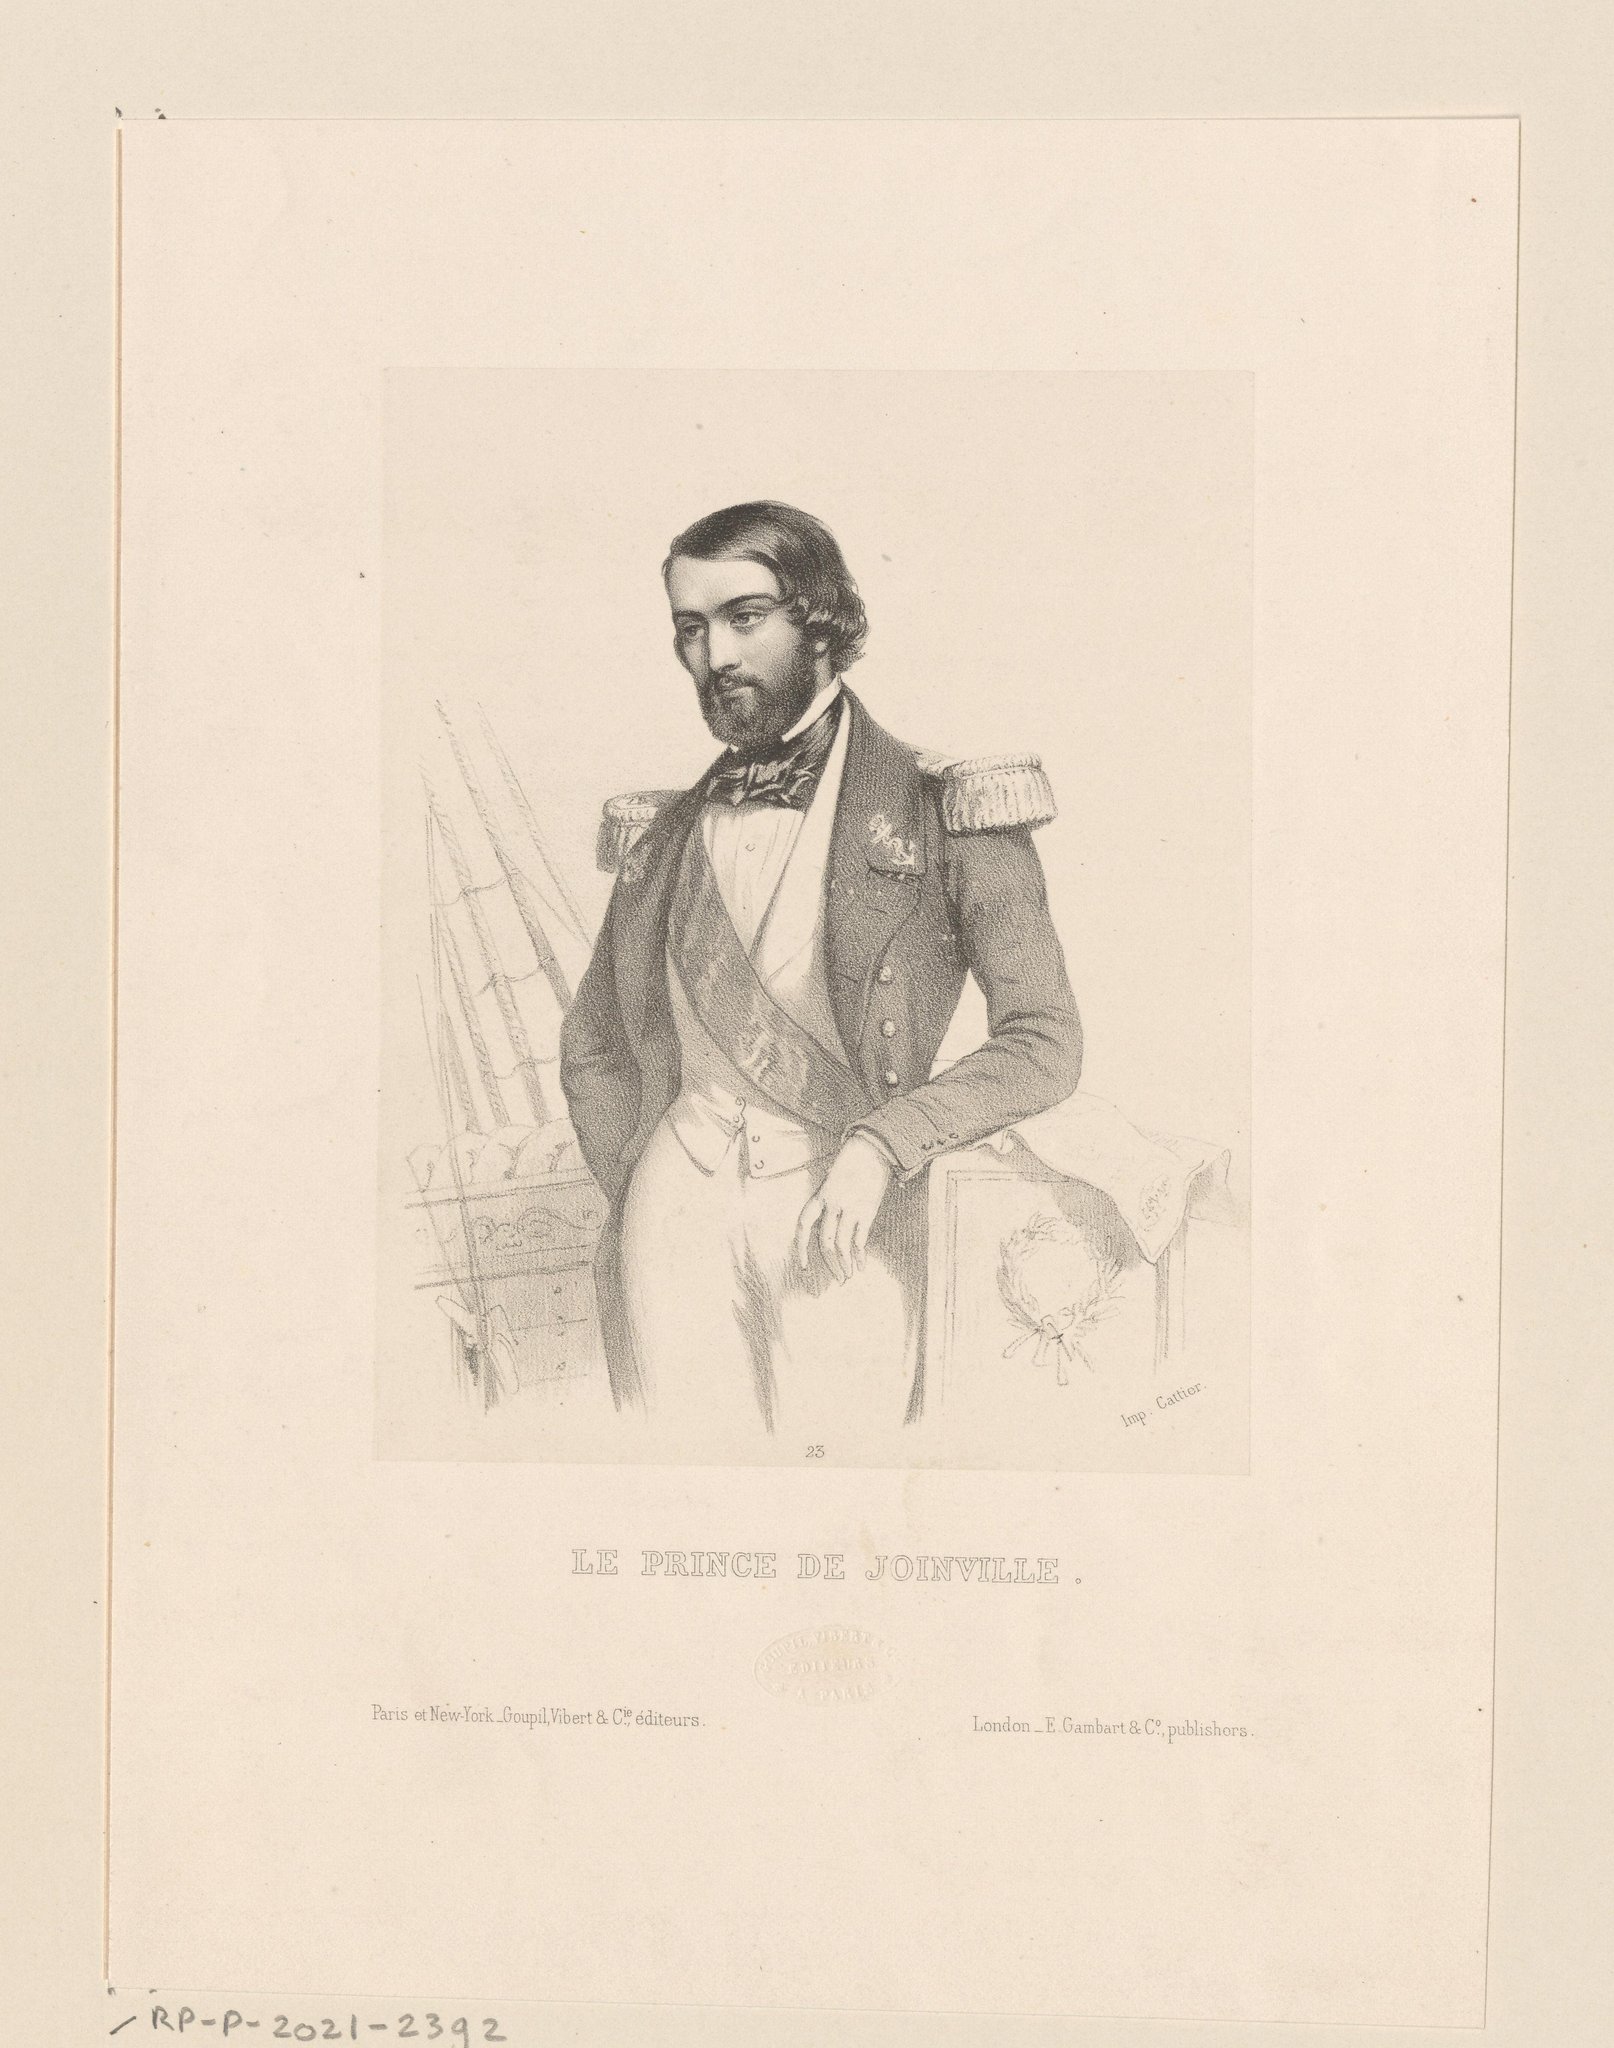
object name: print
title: Portret van Frans Ferdinand Philips Lodewijk Maria van Orleans, prins van Joinville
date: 1841-1850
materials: paper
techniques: lithograph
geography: paris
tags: paris, frans van orléans (prins van joinville), prince, historical persons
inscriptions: check stamp: Lugt 5004